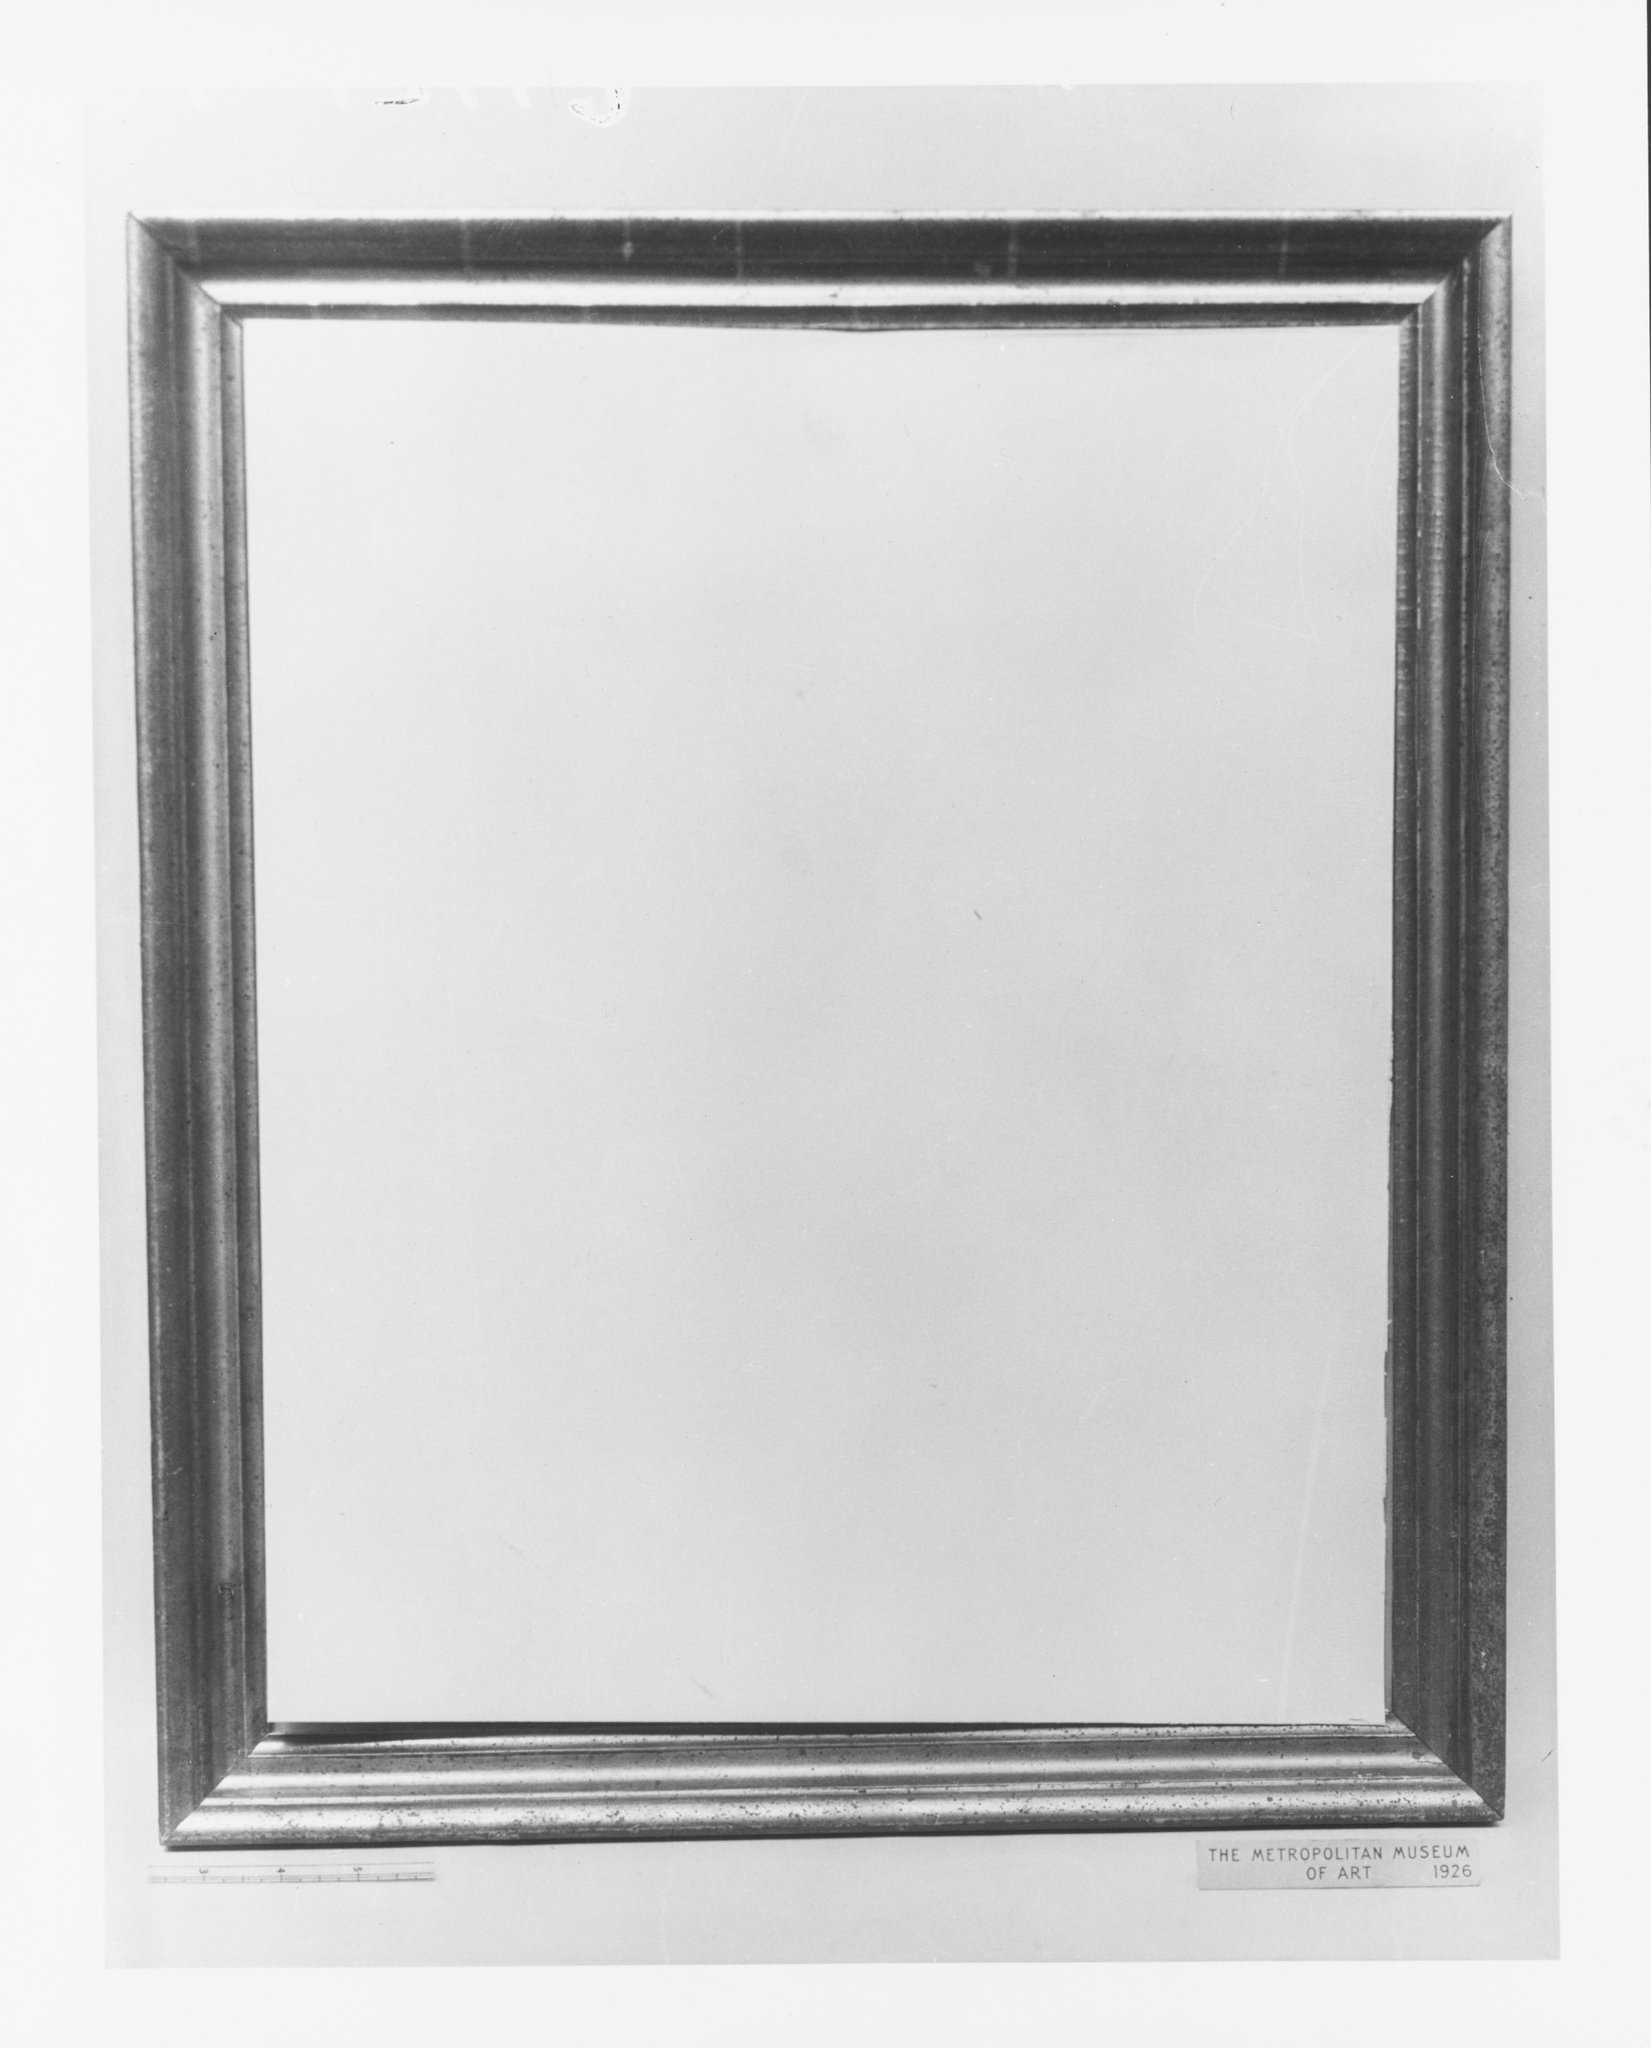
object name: frame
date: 1830-1870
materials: gilt, wood